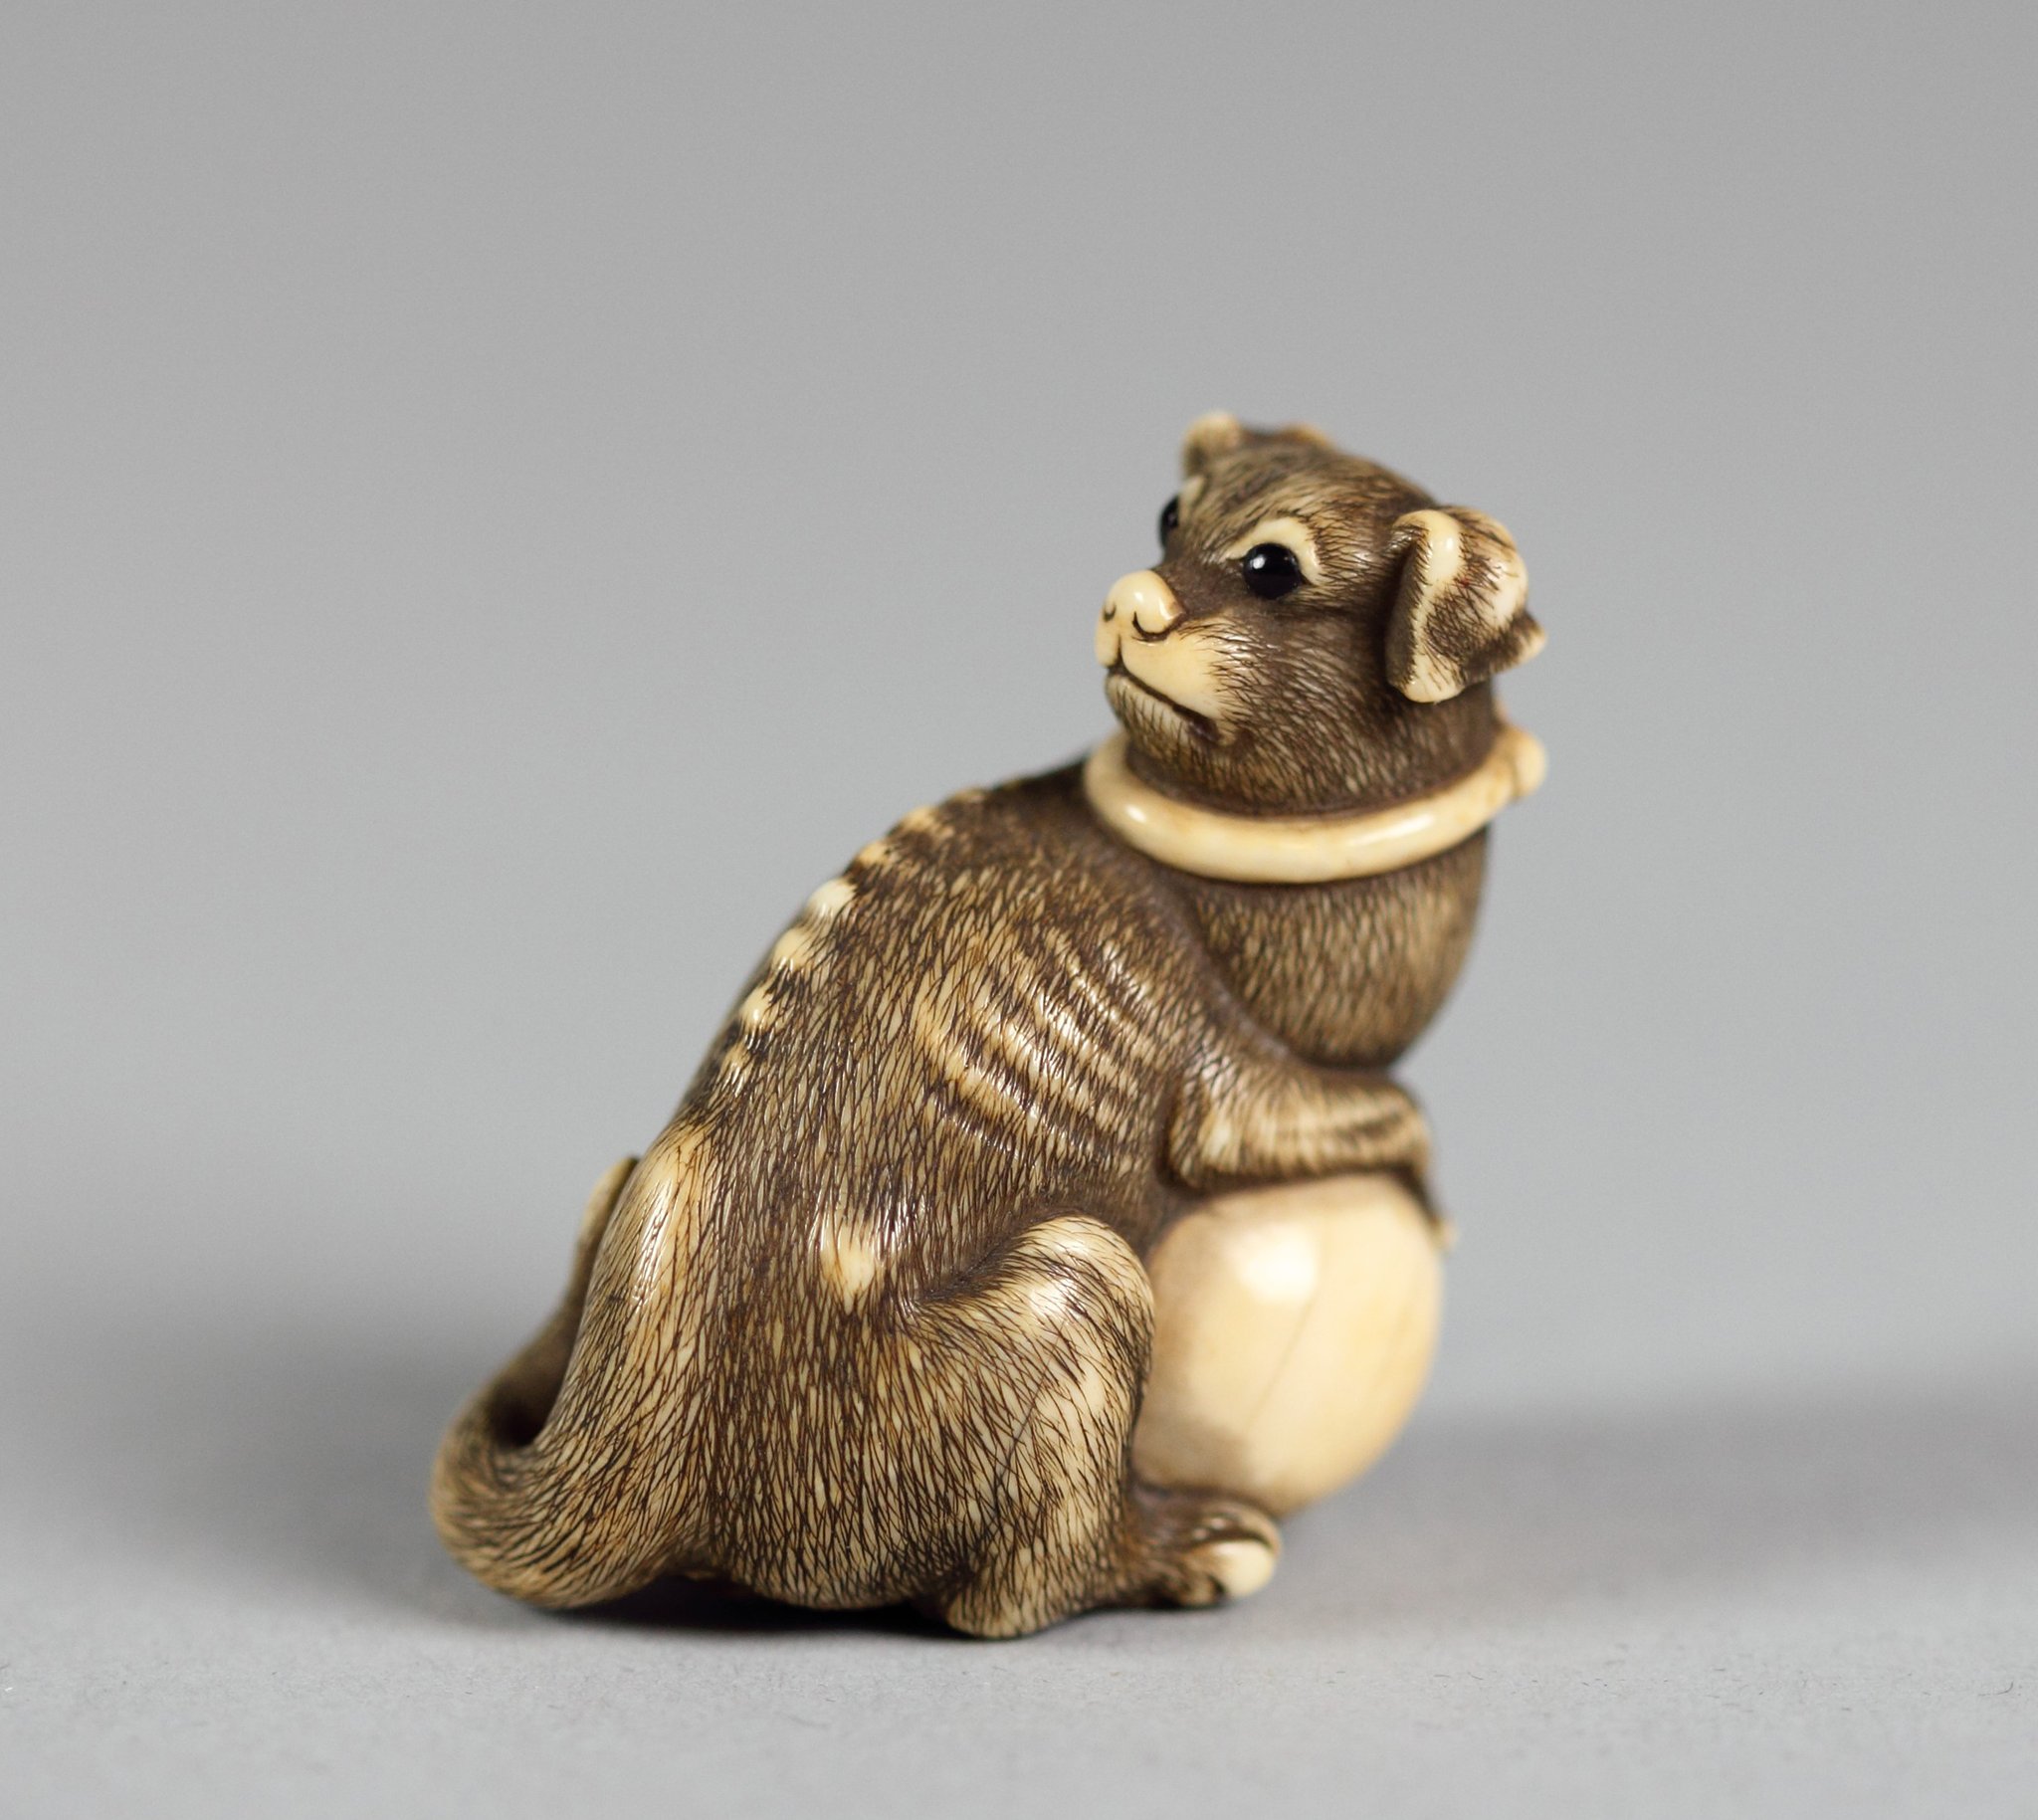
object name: netsuke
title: Netsuke of Cat with a Ball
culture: japanese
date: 1801-1900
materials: ivory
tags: cats